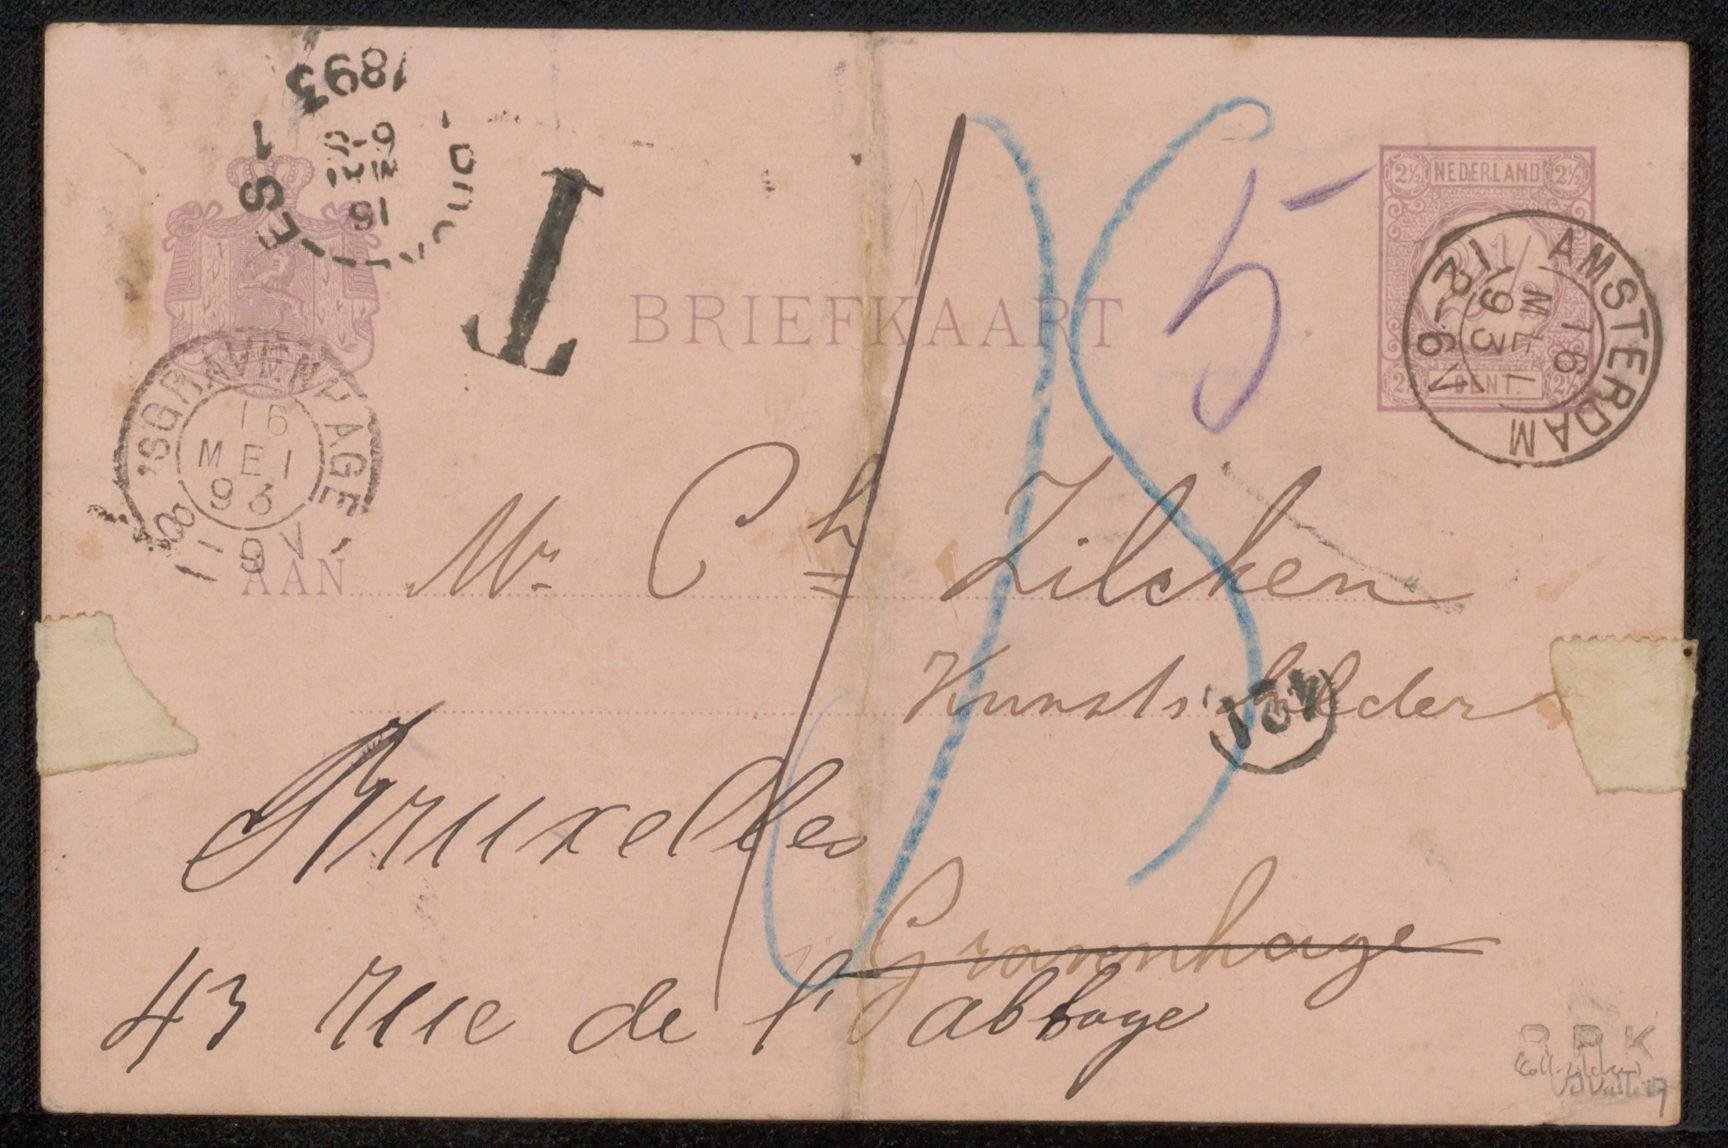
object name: postcard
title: Briefkaart aan Philip Zilcken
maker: maurits van der valk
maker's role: draughtsman, print maker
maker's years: 1857-1935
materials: cardboard, ink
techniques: pen, writing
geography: amsterdam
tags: the hague, painter, draughtsman, philip zilcken, the graphic arts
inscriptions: collector's mark: ‘RPK’